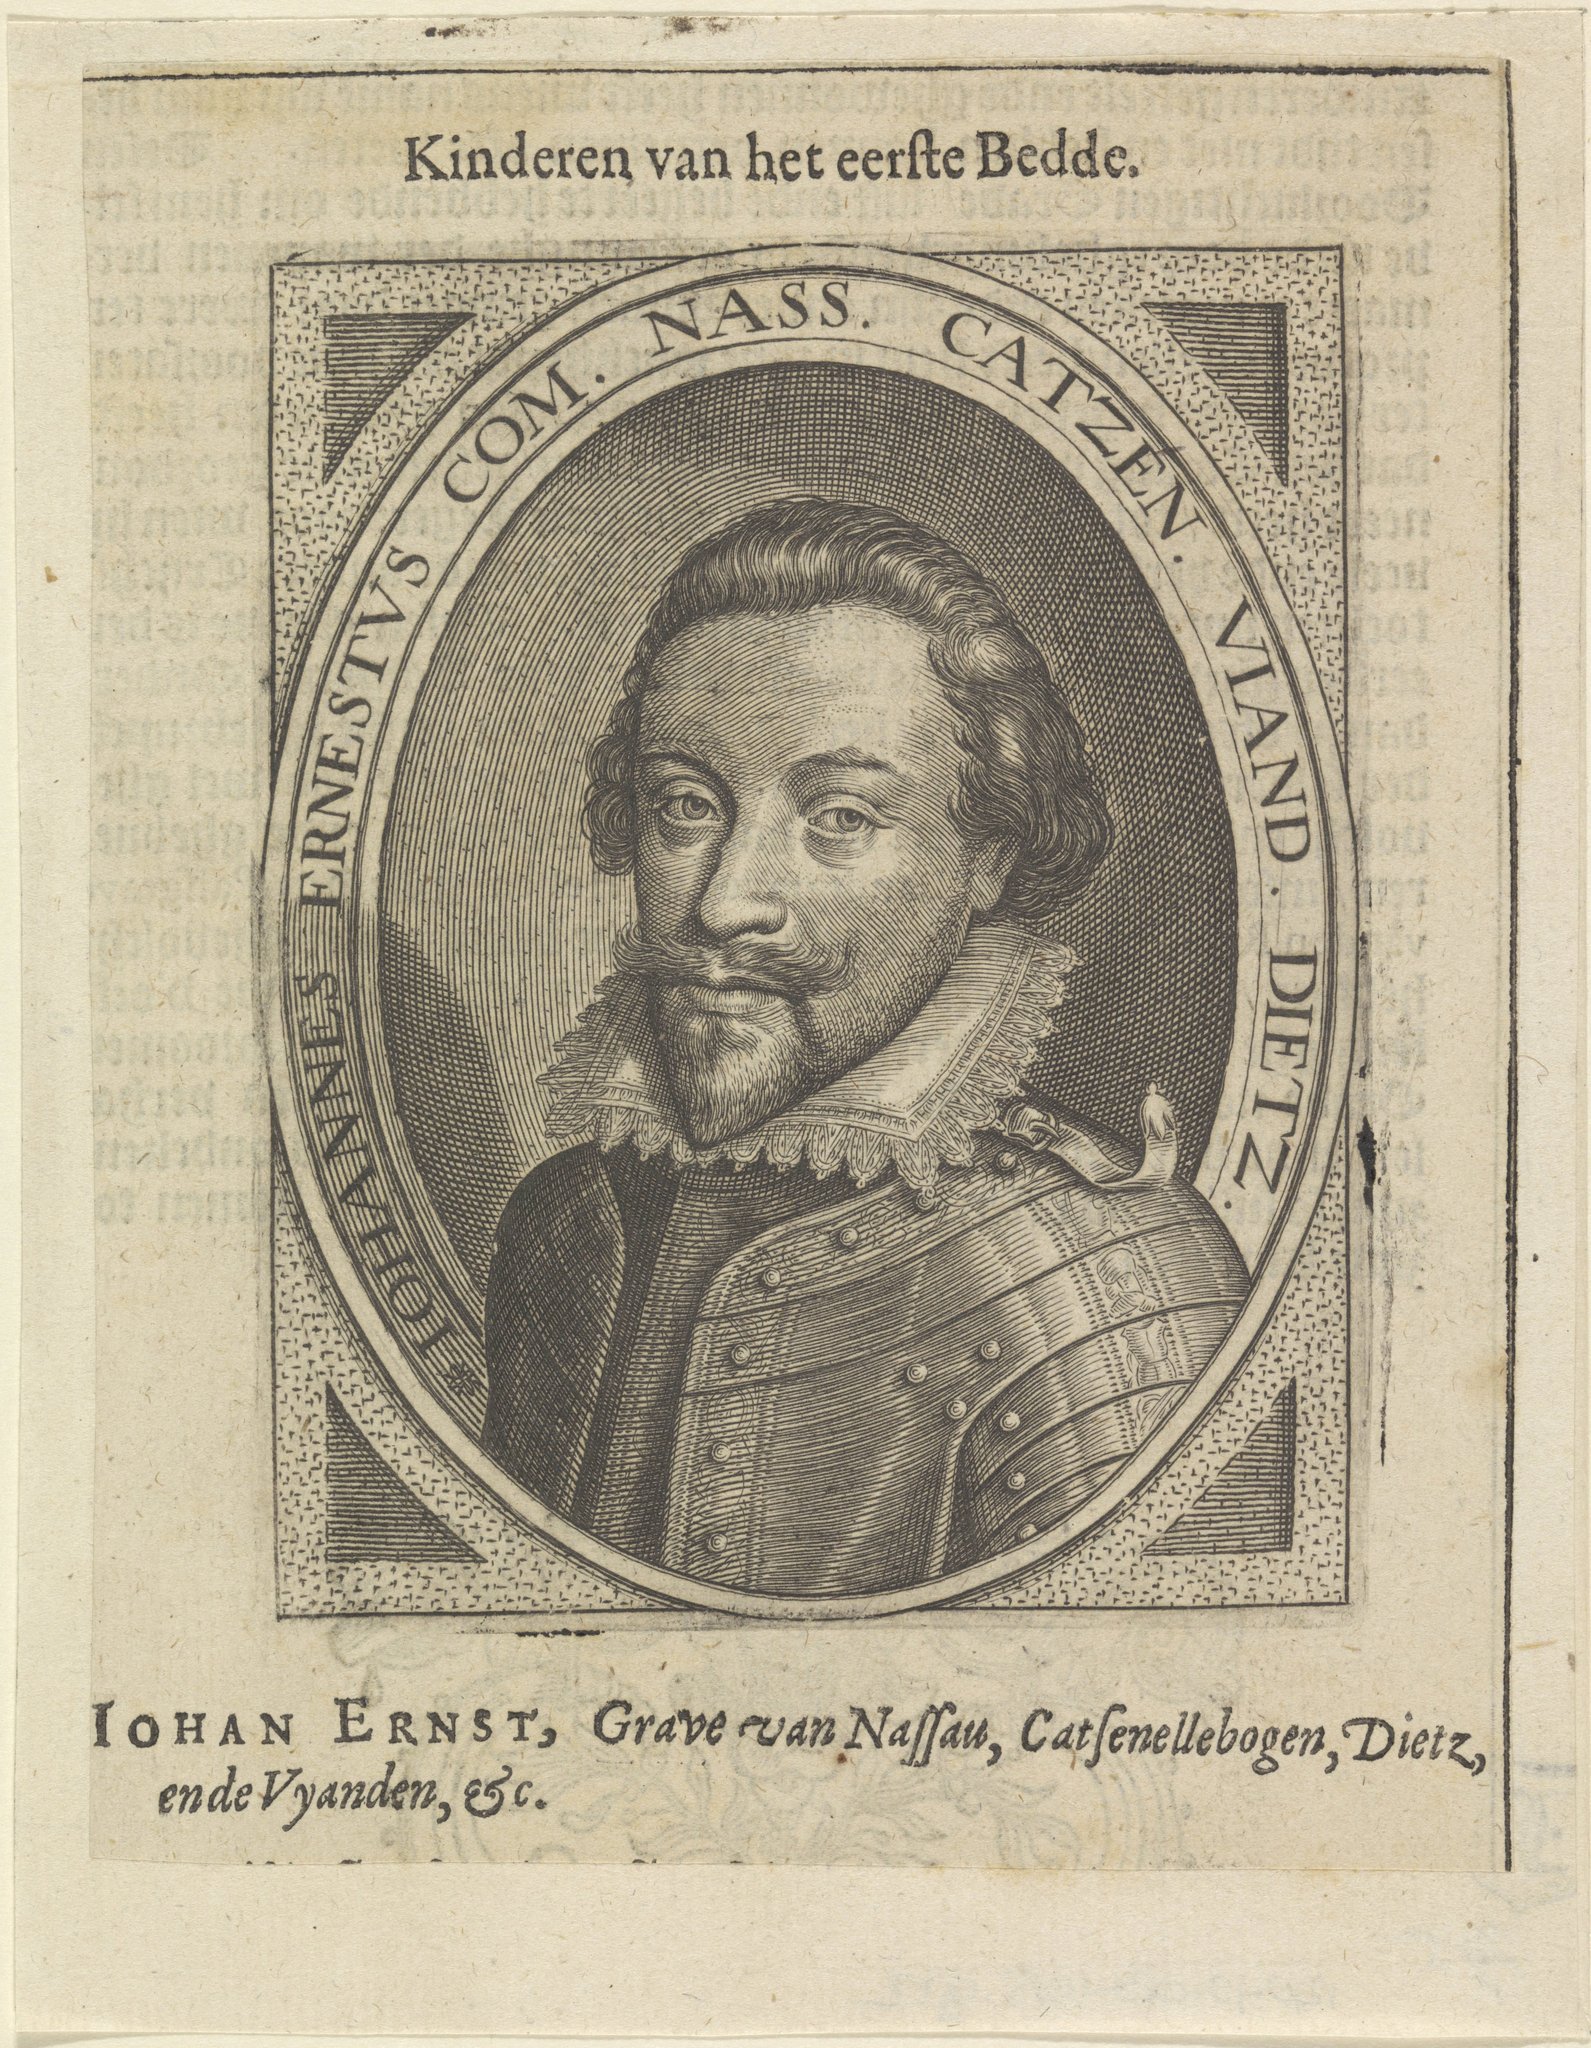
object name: book illustration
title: Portret van Johan Ernst I, graaf van Nassau-Siegen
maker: Anonymous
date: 1600-1699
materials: paper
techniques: engraving, etching, letterpress printing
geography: low countries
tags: johan ernst i graaf van nassau-siegen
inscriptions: collector's mark: Lugt 963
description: De hier vermelde titel verwijst naar de hoogst verkregen titel van de geportretteerde, niet per se naar de titel die de geportretteerde op deze voorstelling draagt.